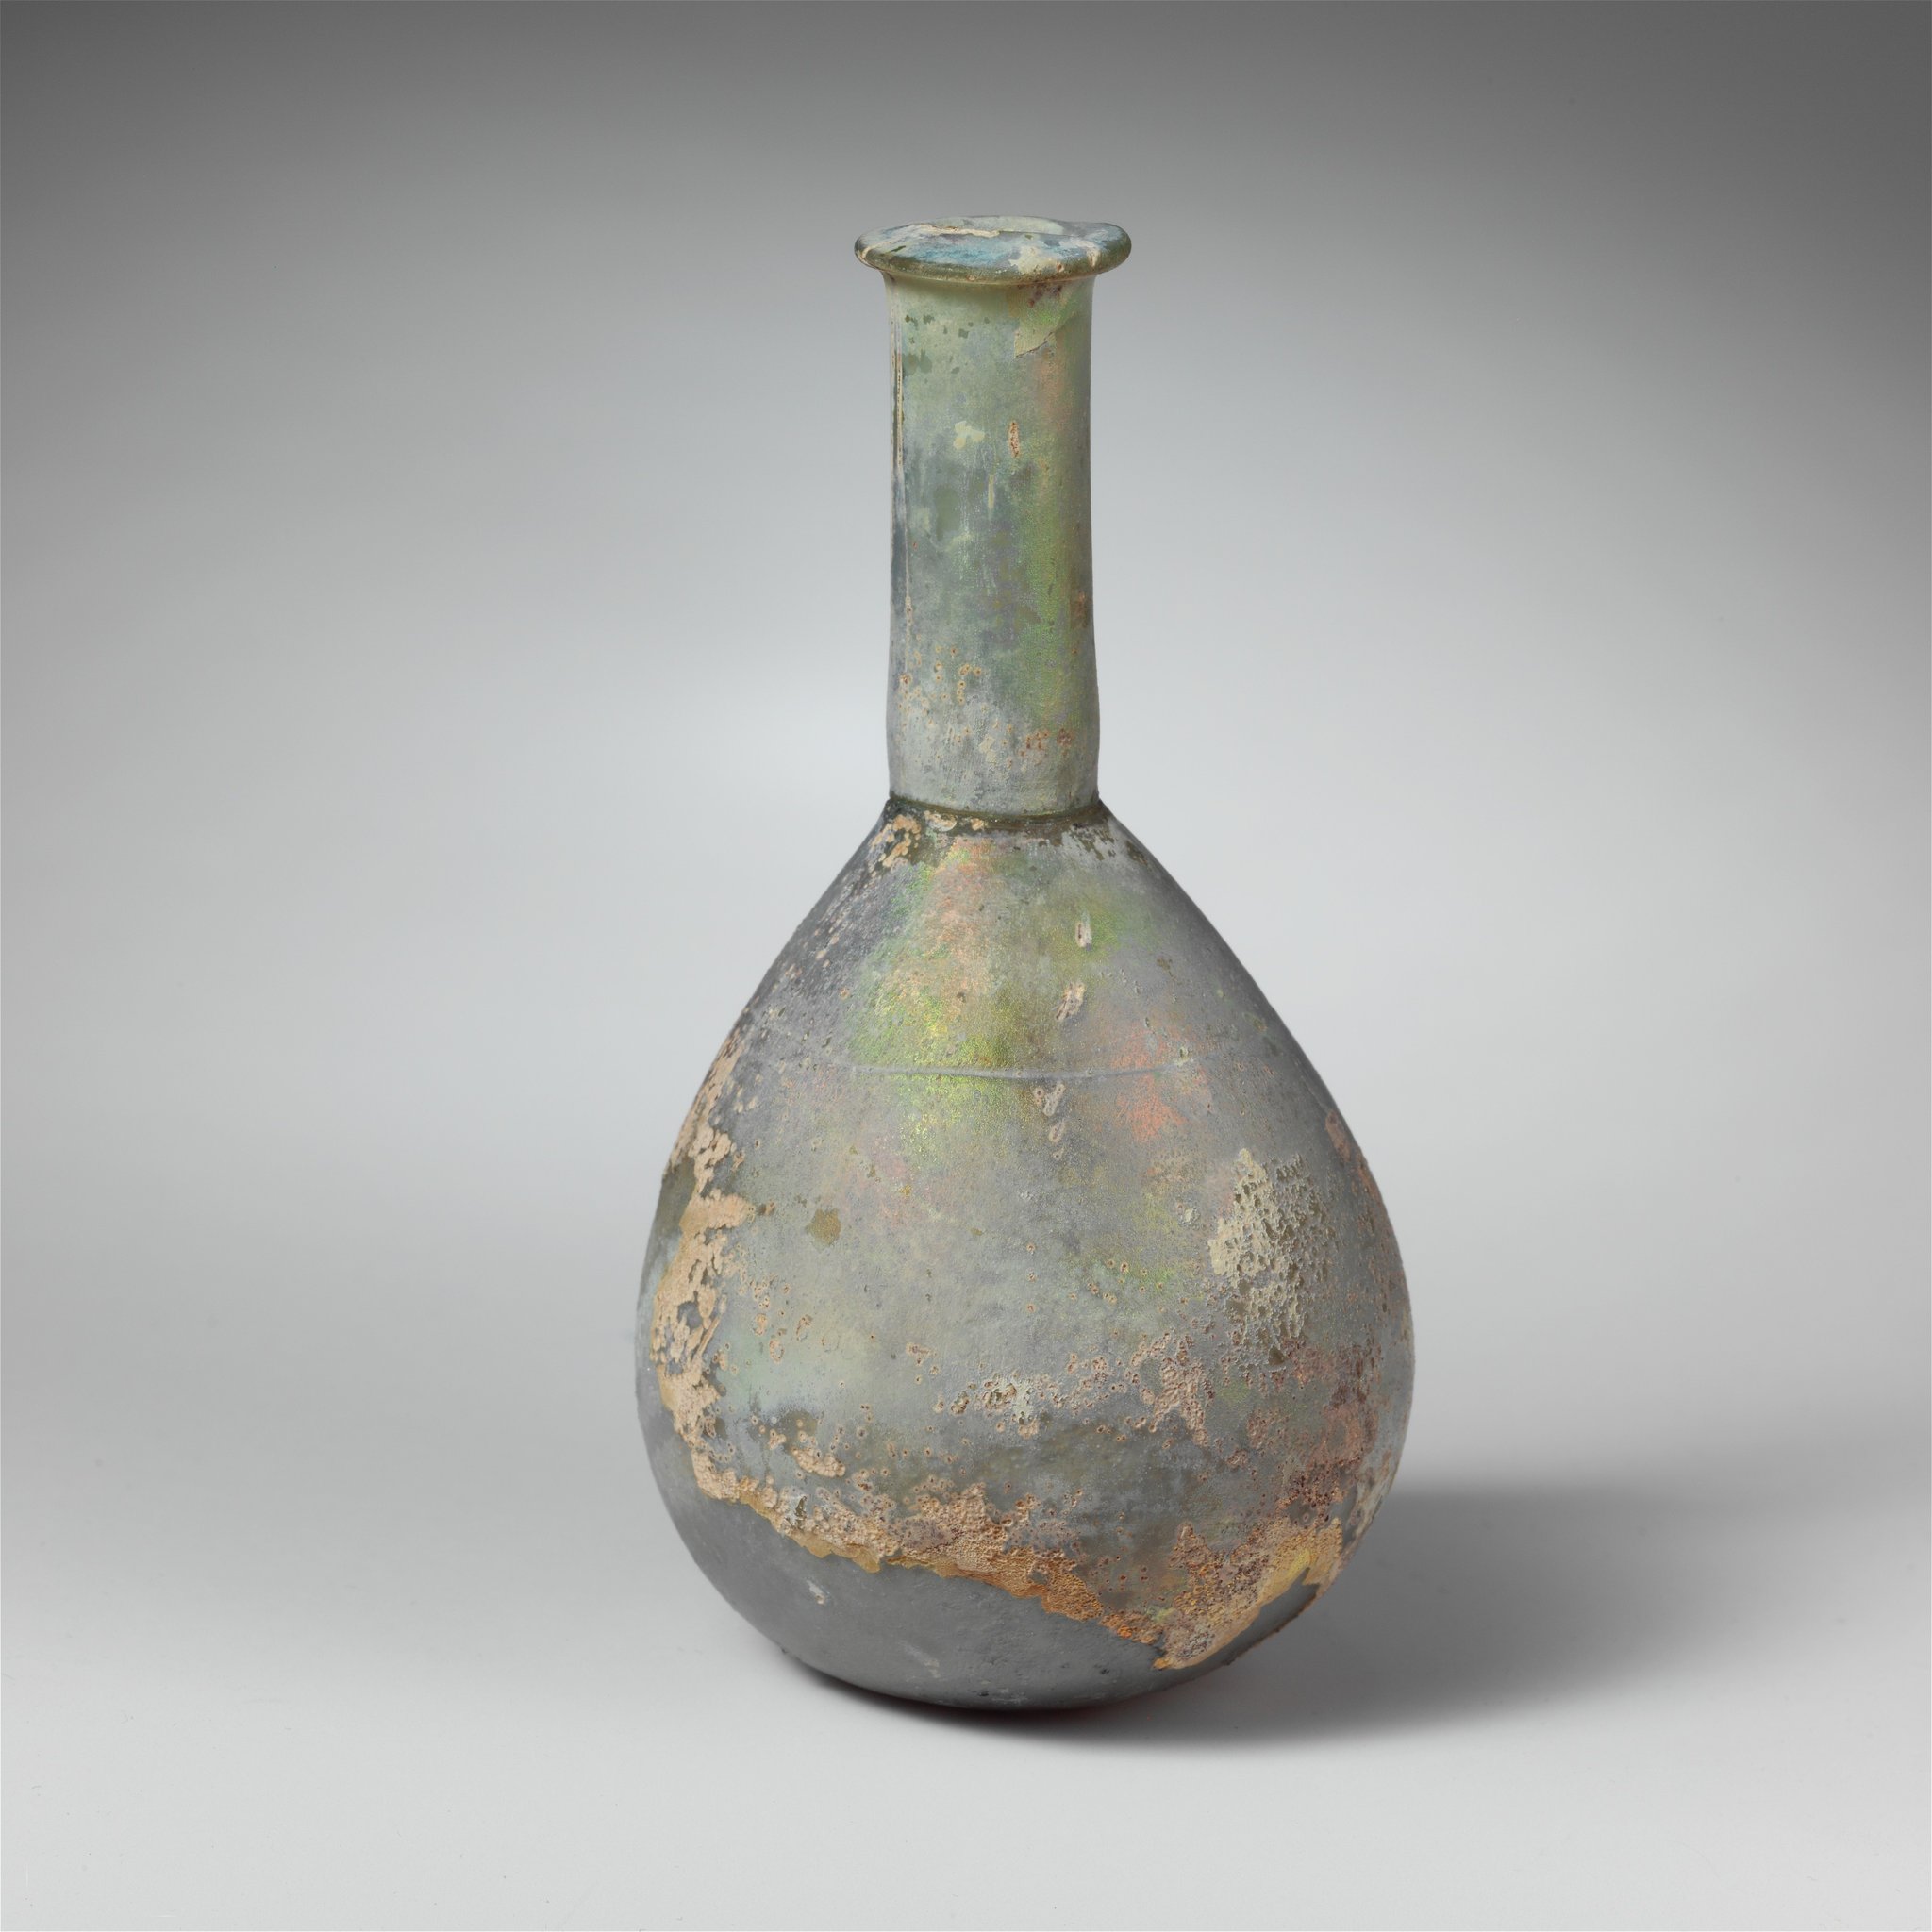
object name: perfume bottle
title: Glass perfume bottle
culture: roman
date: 1-200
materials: glass